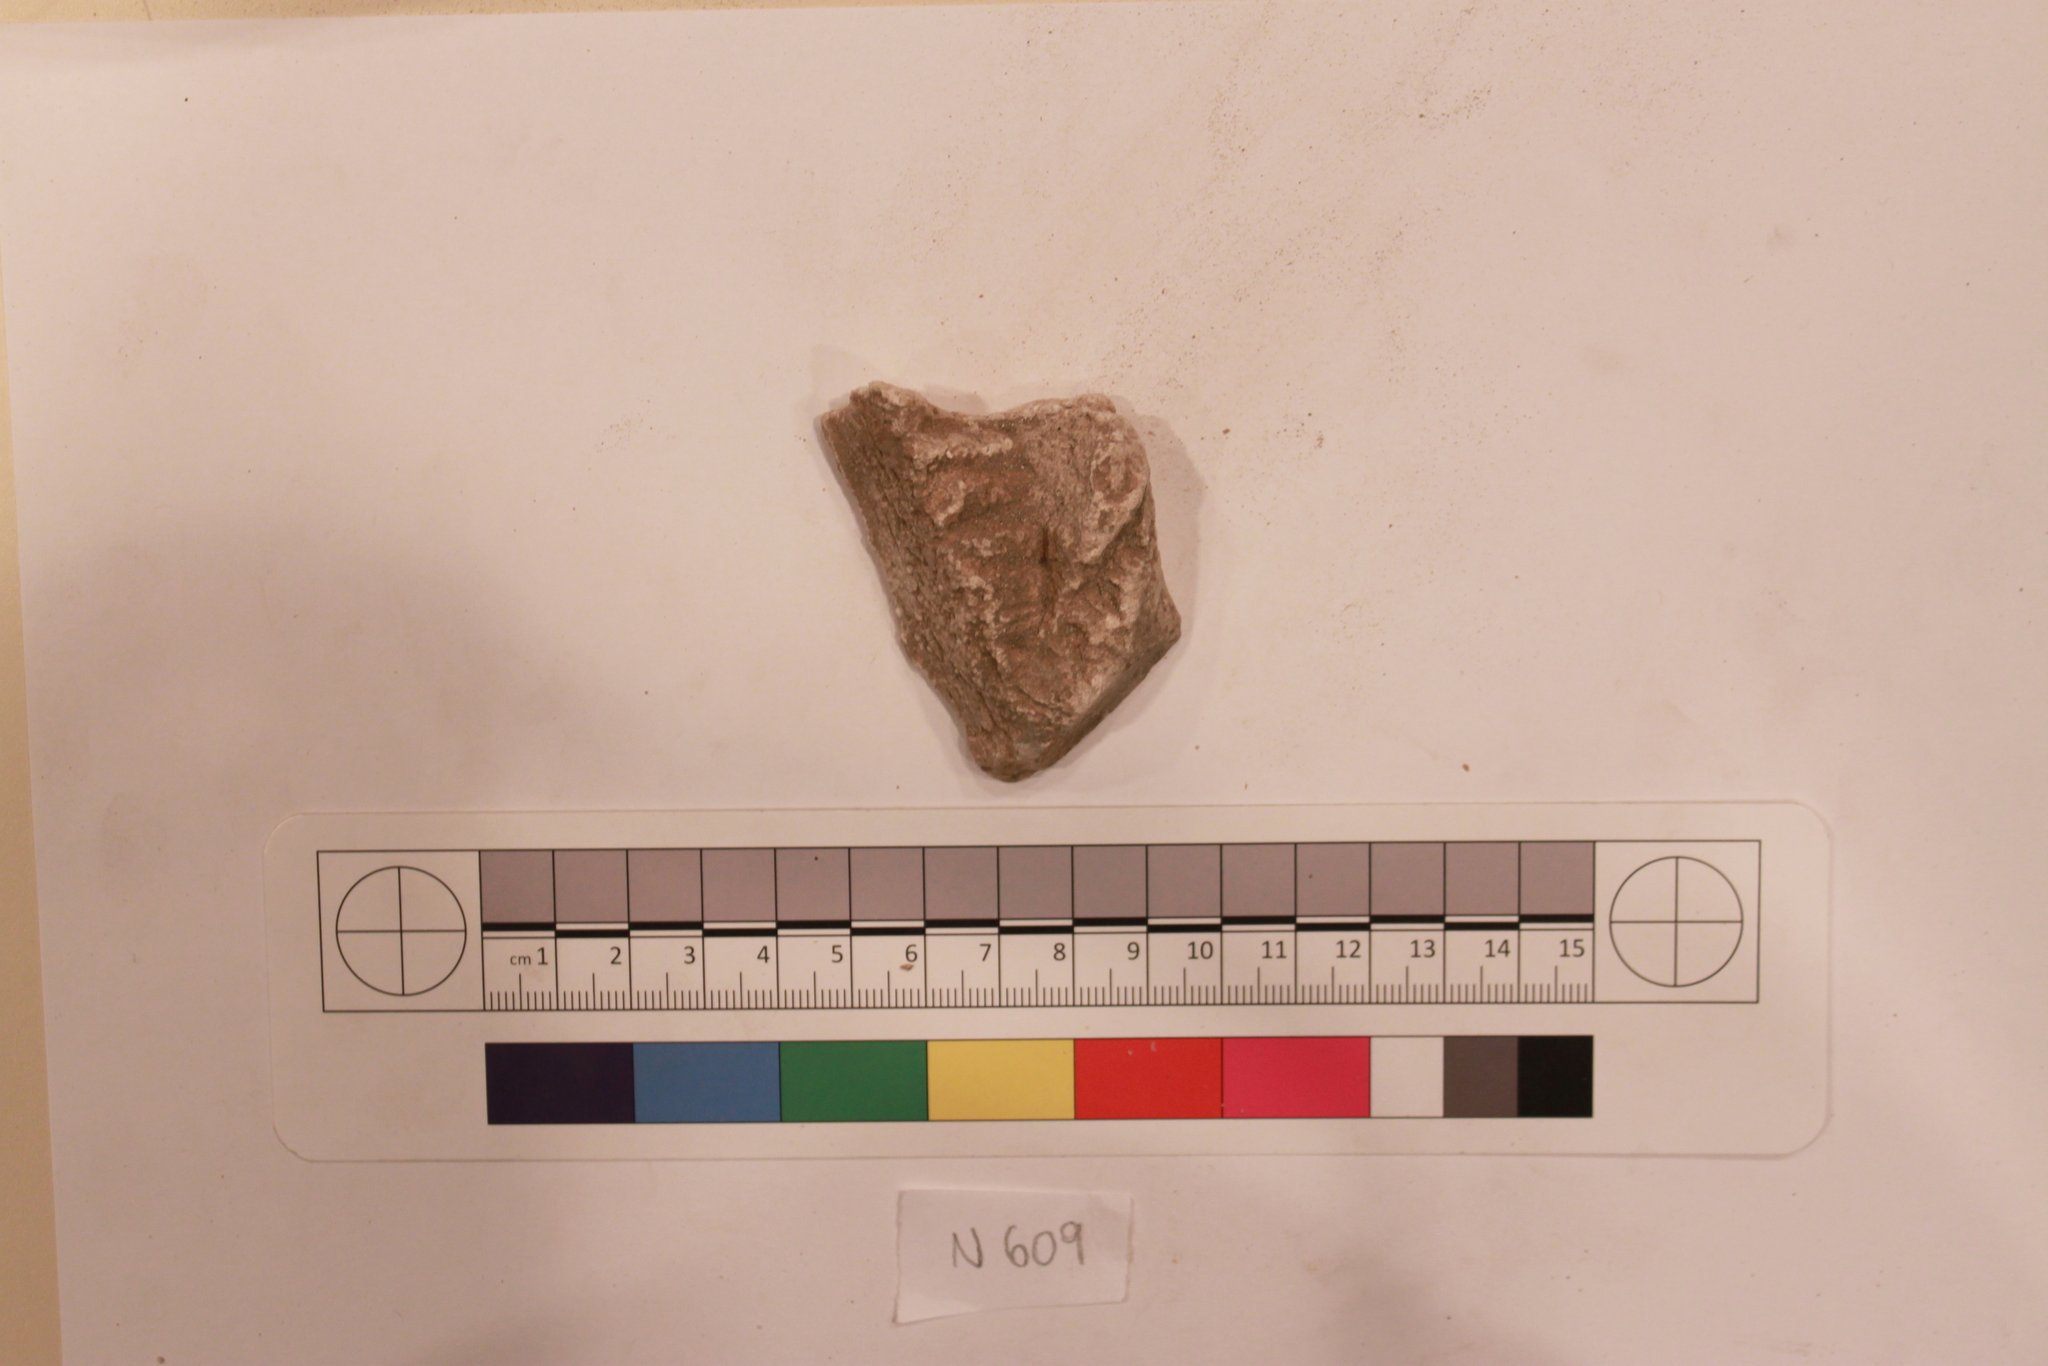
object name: fragment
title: Stucco Fragment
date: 701-1200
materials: plaster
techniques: carving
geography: iran